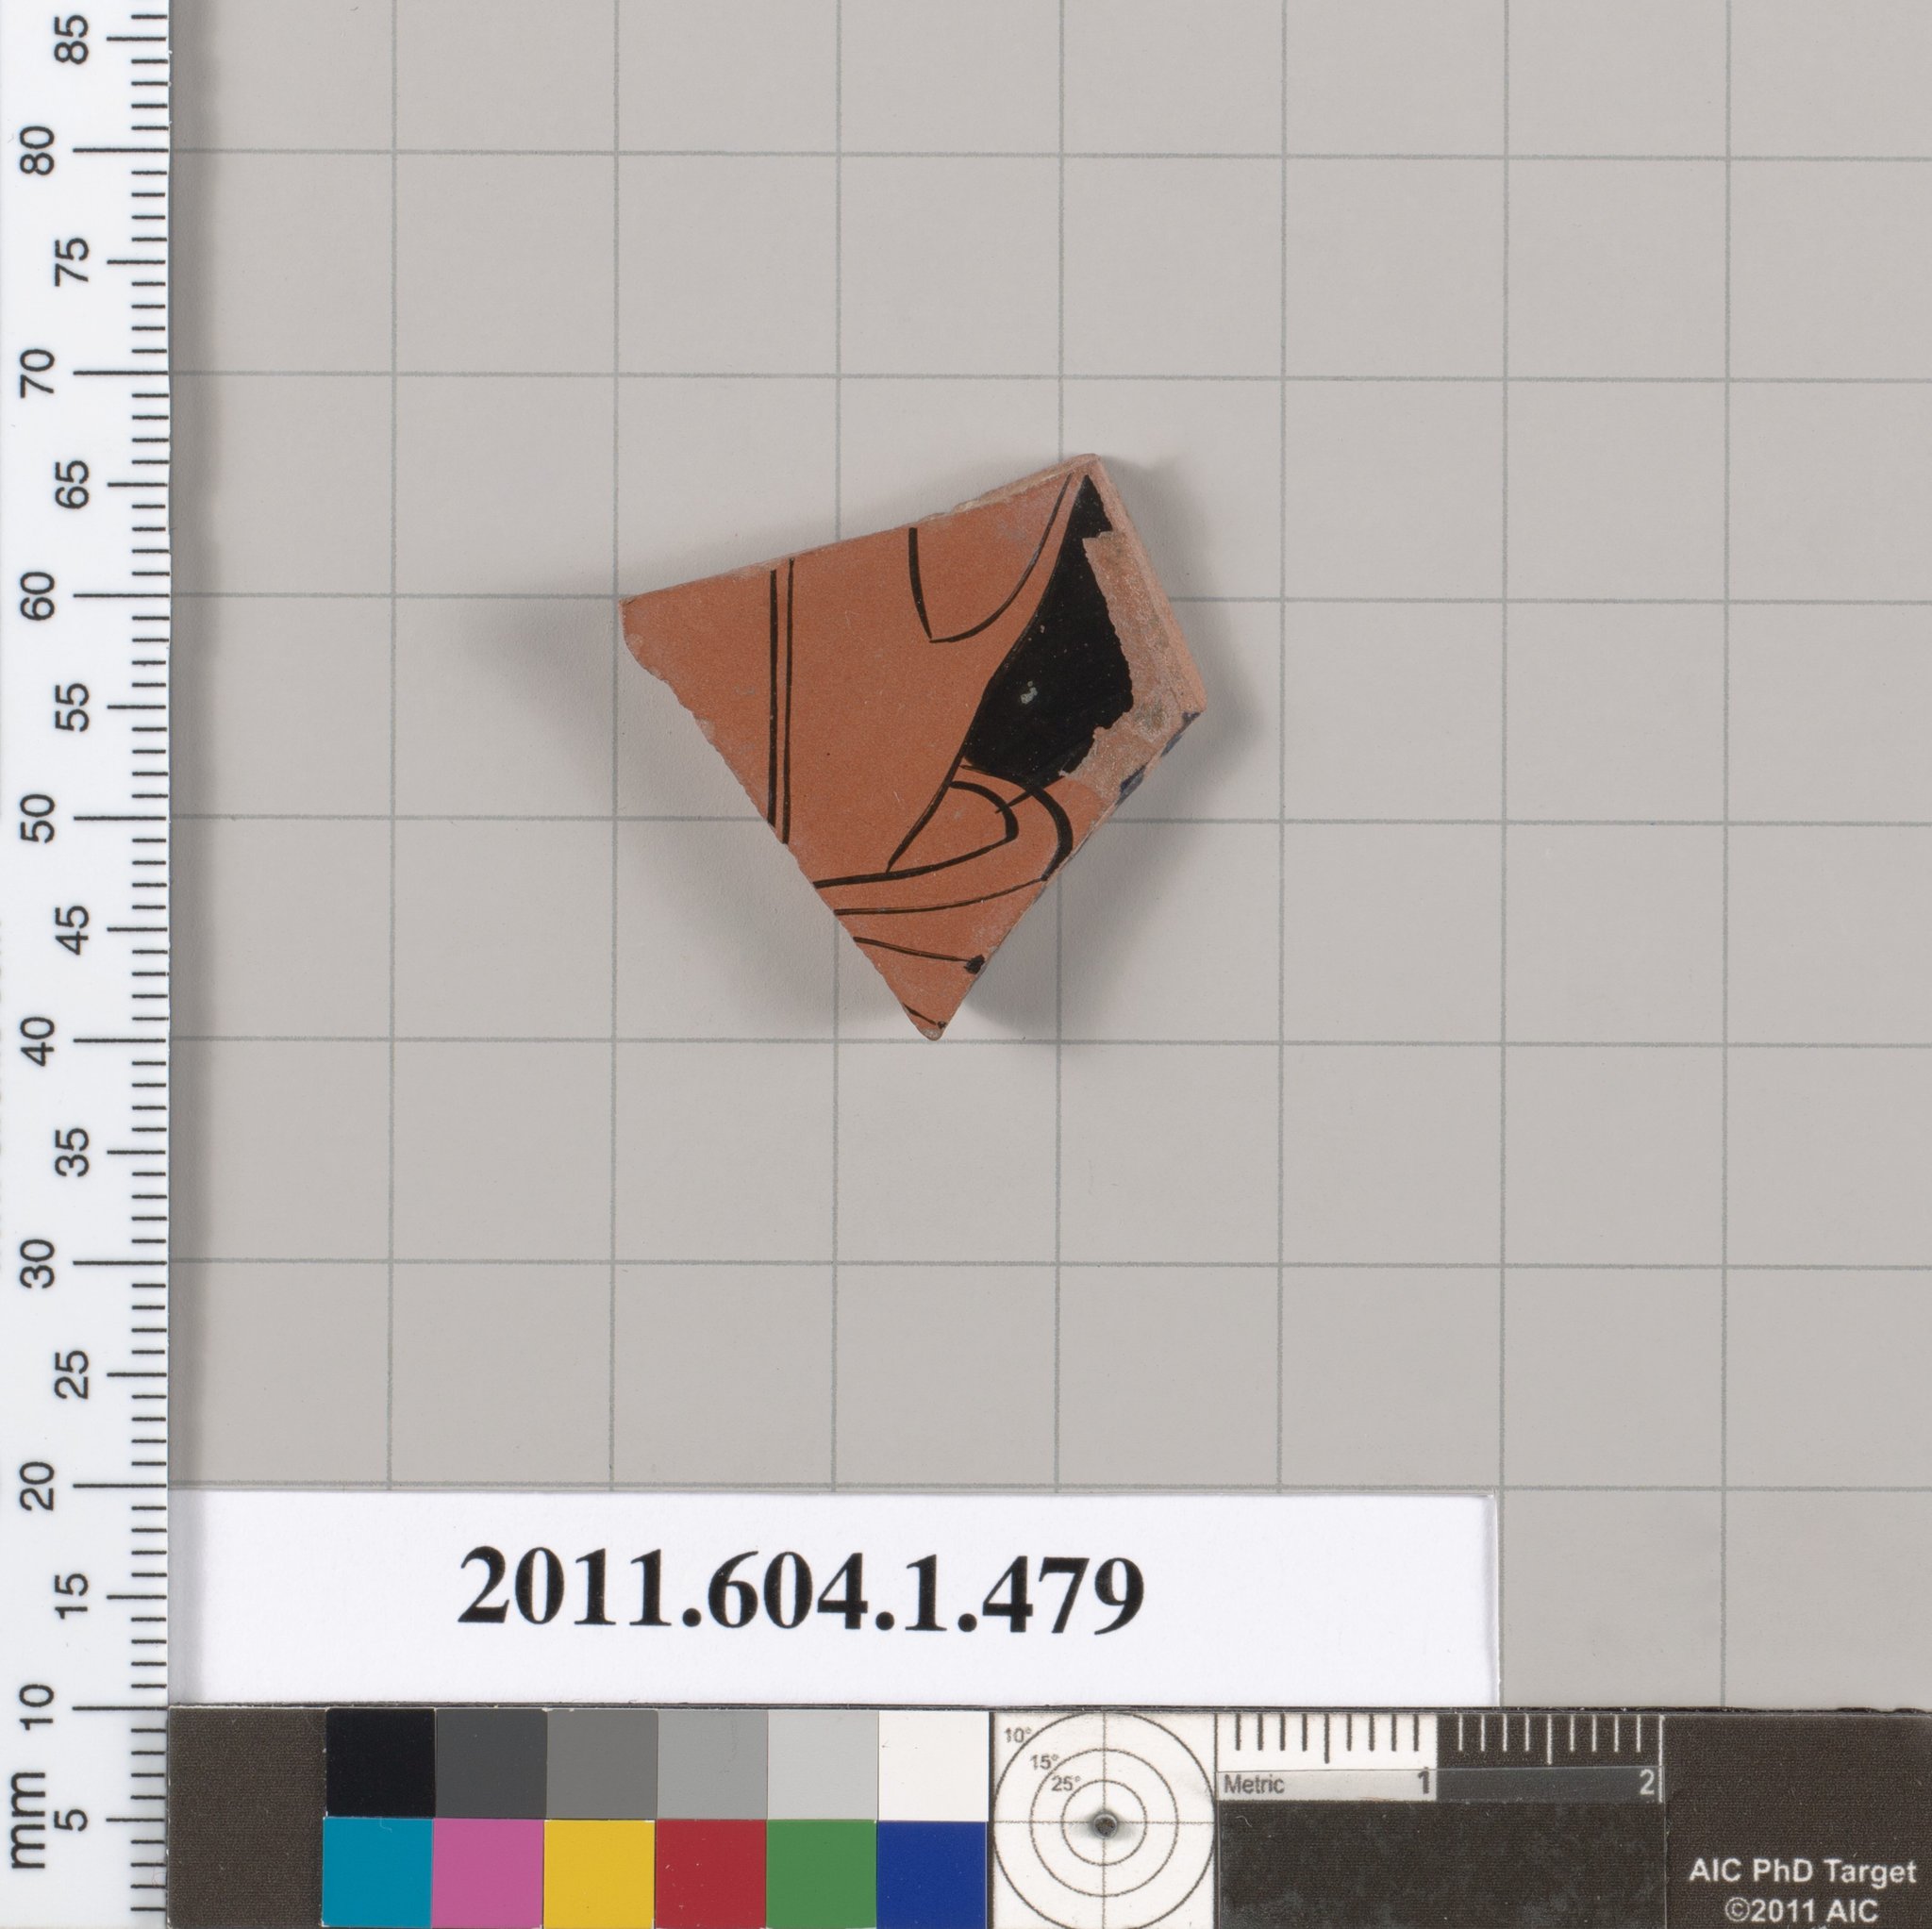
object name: kylix fragment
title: Terracotta fragment of a kylix (drinking cup)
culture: greek, attic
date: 490-480 BCE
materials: terracotta